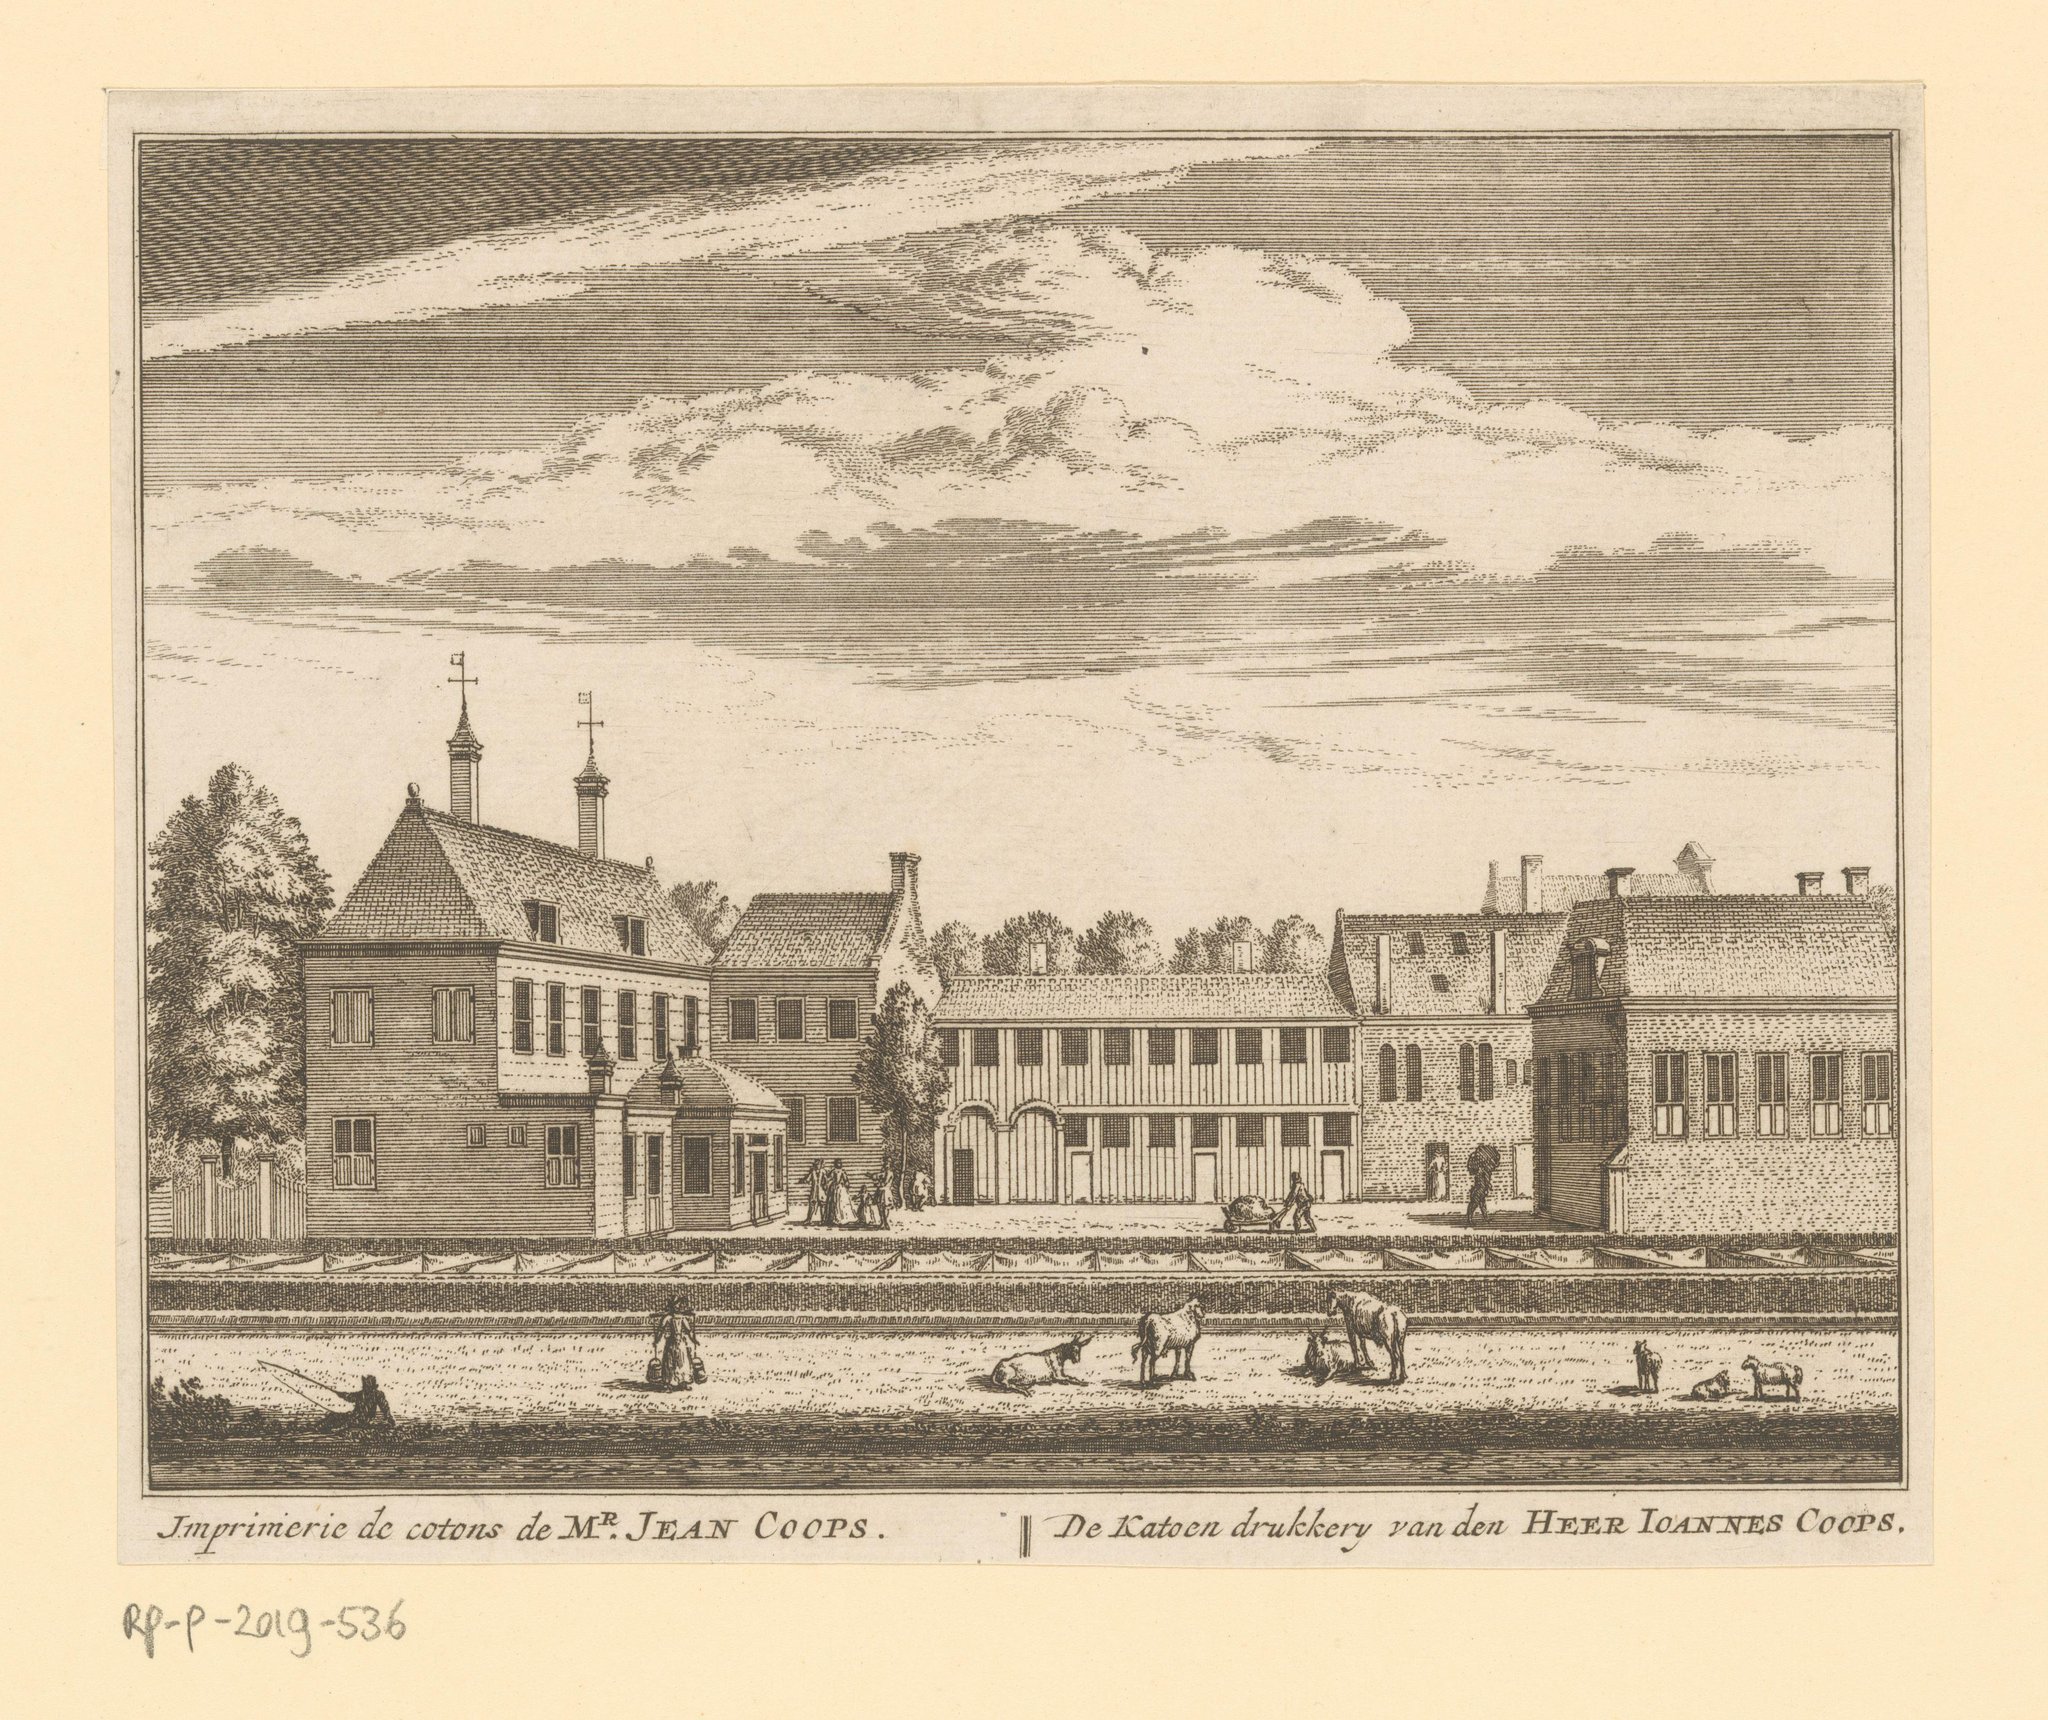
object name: print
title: Gezicht op de katoendrukkerij van Joannes Coops aan de Amsteldijk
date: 1730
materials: paper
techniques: engraving, etching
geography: amsterdam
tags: cotton (material ~ textile industry), street (+ city(-scape) with figures, staffage)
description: Prent mogelijk uit: Hollandse Arkadia. Amsterdam: Leonard Schenk, 1730.